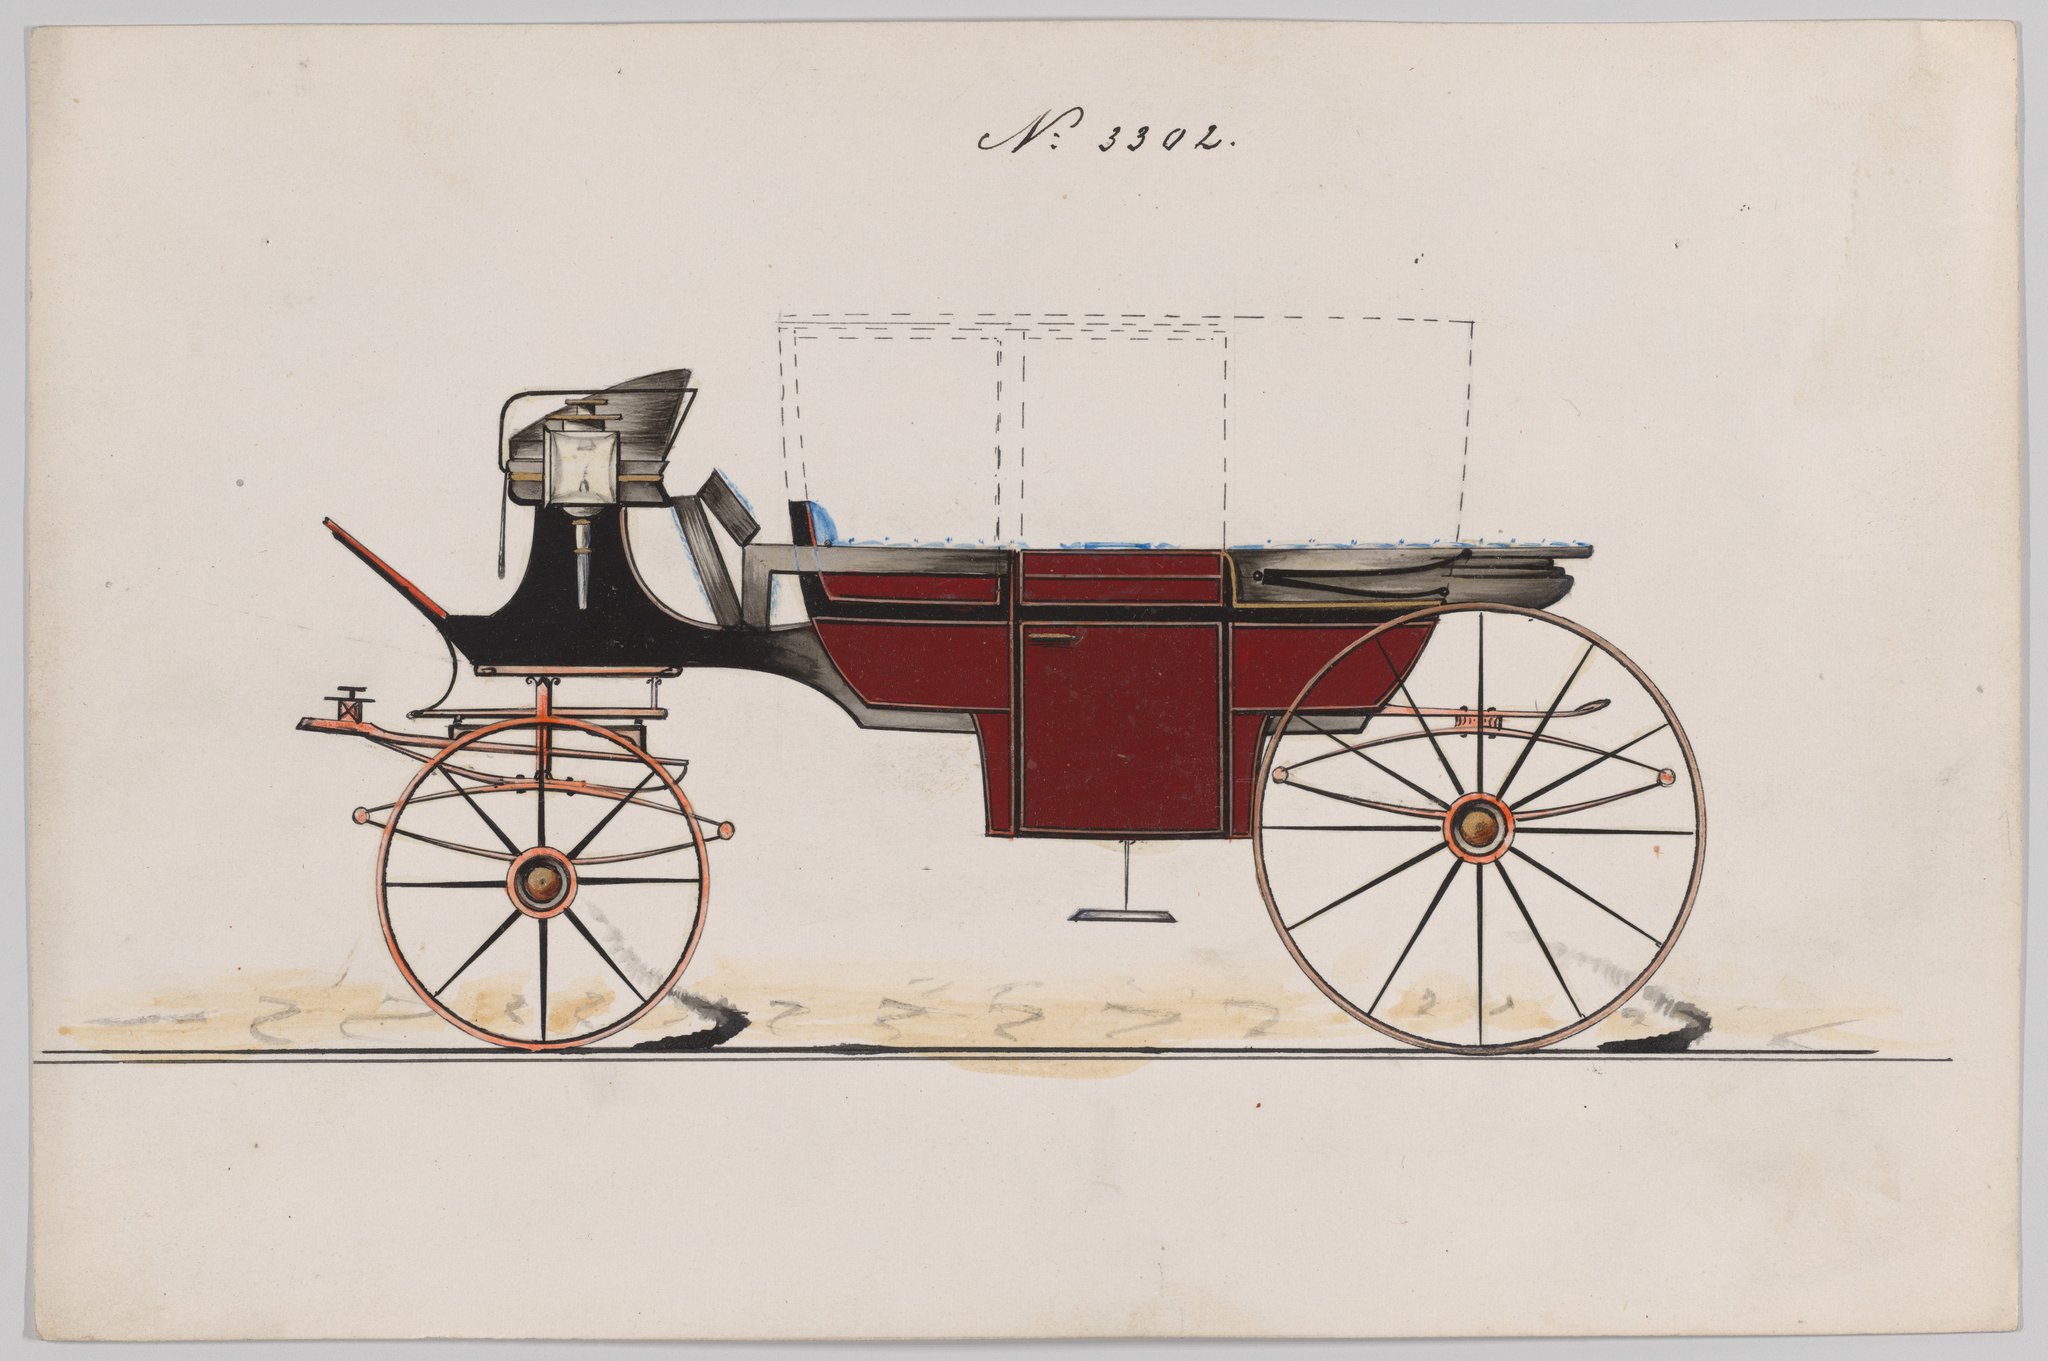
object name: drawing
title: Design for Landau, No. 3302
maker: brewster & co.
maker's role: manufacturer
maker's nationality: american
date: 1877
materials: gouache, gum arabic, ink, watercolor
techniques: pen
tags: carriages